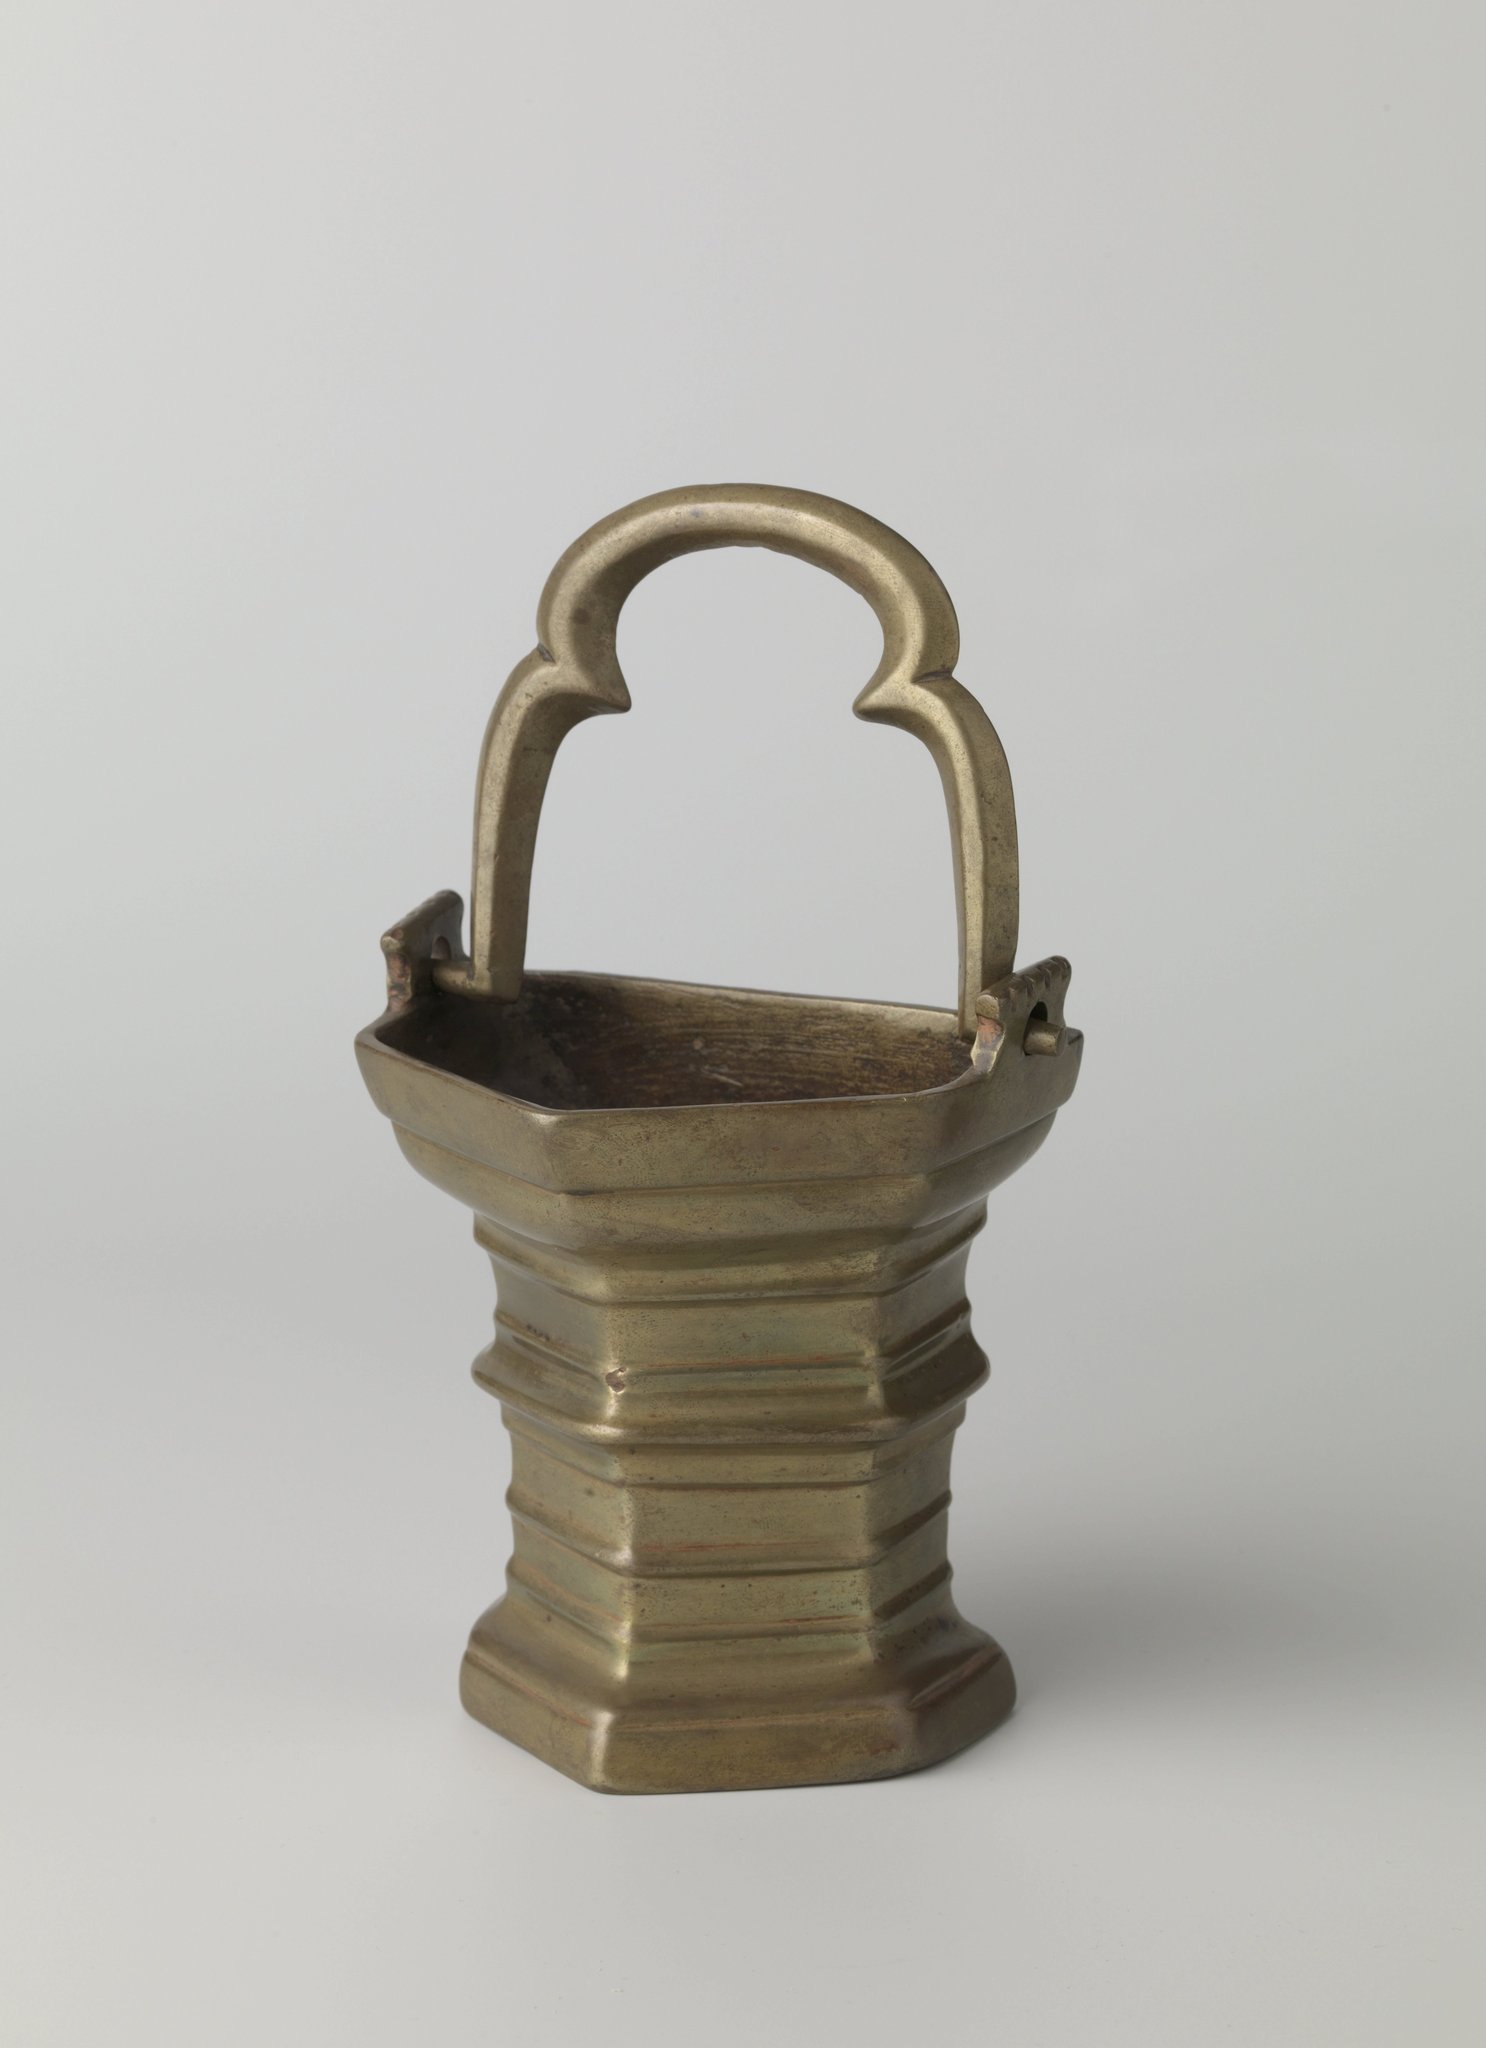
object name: aspersorium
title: Wijwateremmer, vijfzijdig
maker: Anonymous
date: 1475-1525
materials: brass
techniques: casting, metalworking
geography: southern netherlands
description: Holy water vessel. Brass Southern Netherlands or Germany, c. 1500.